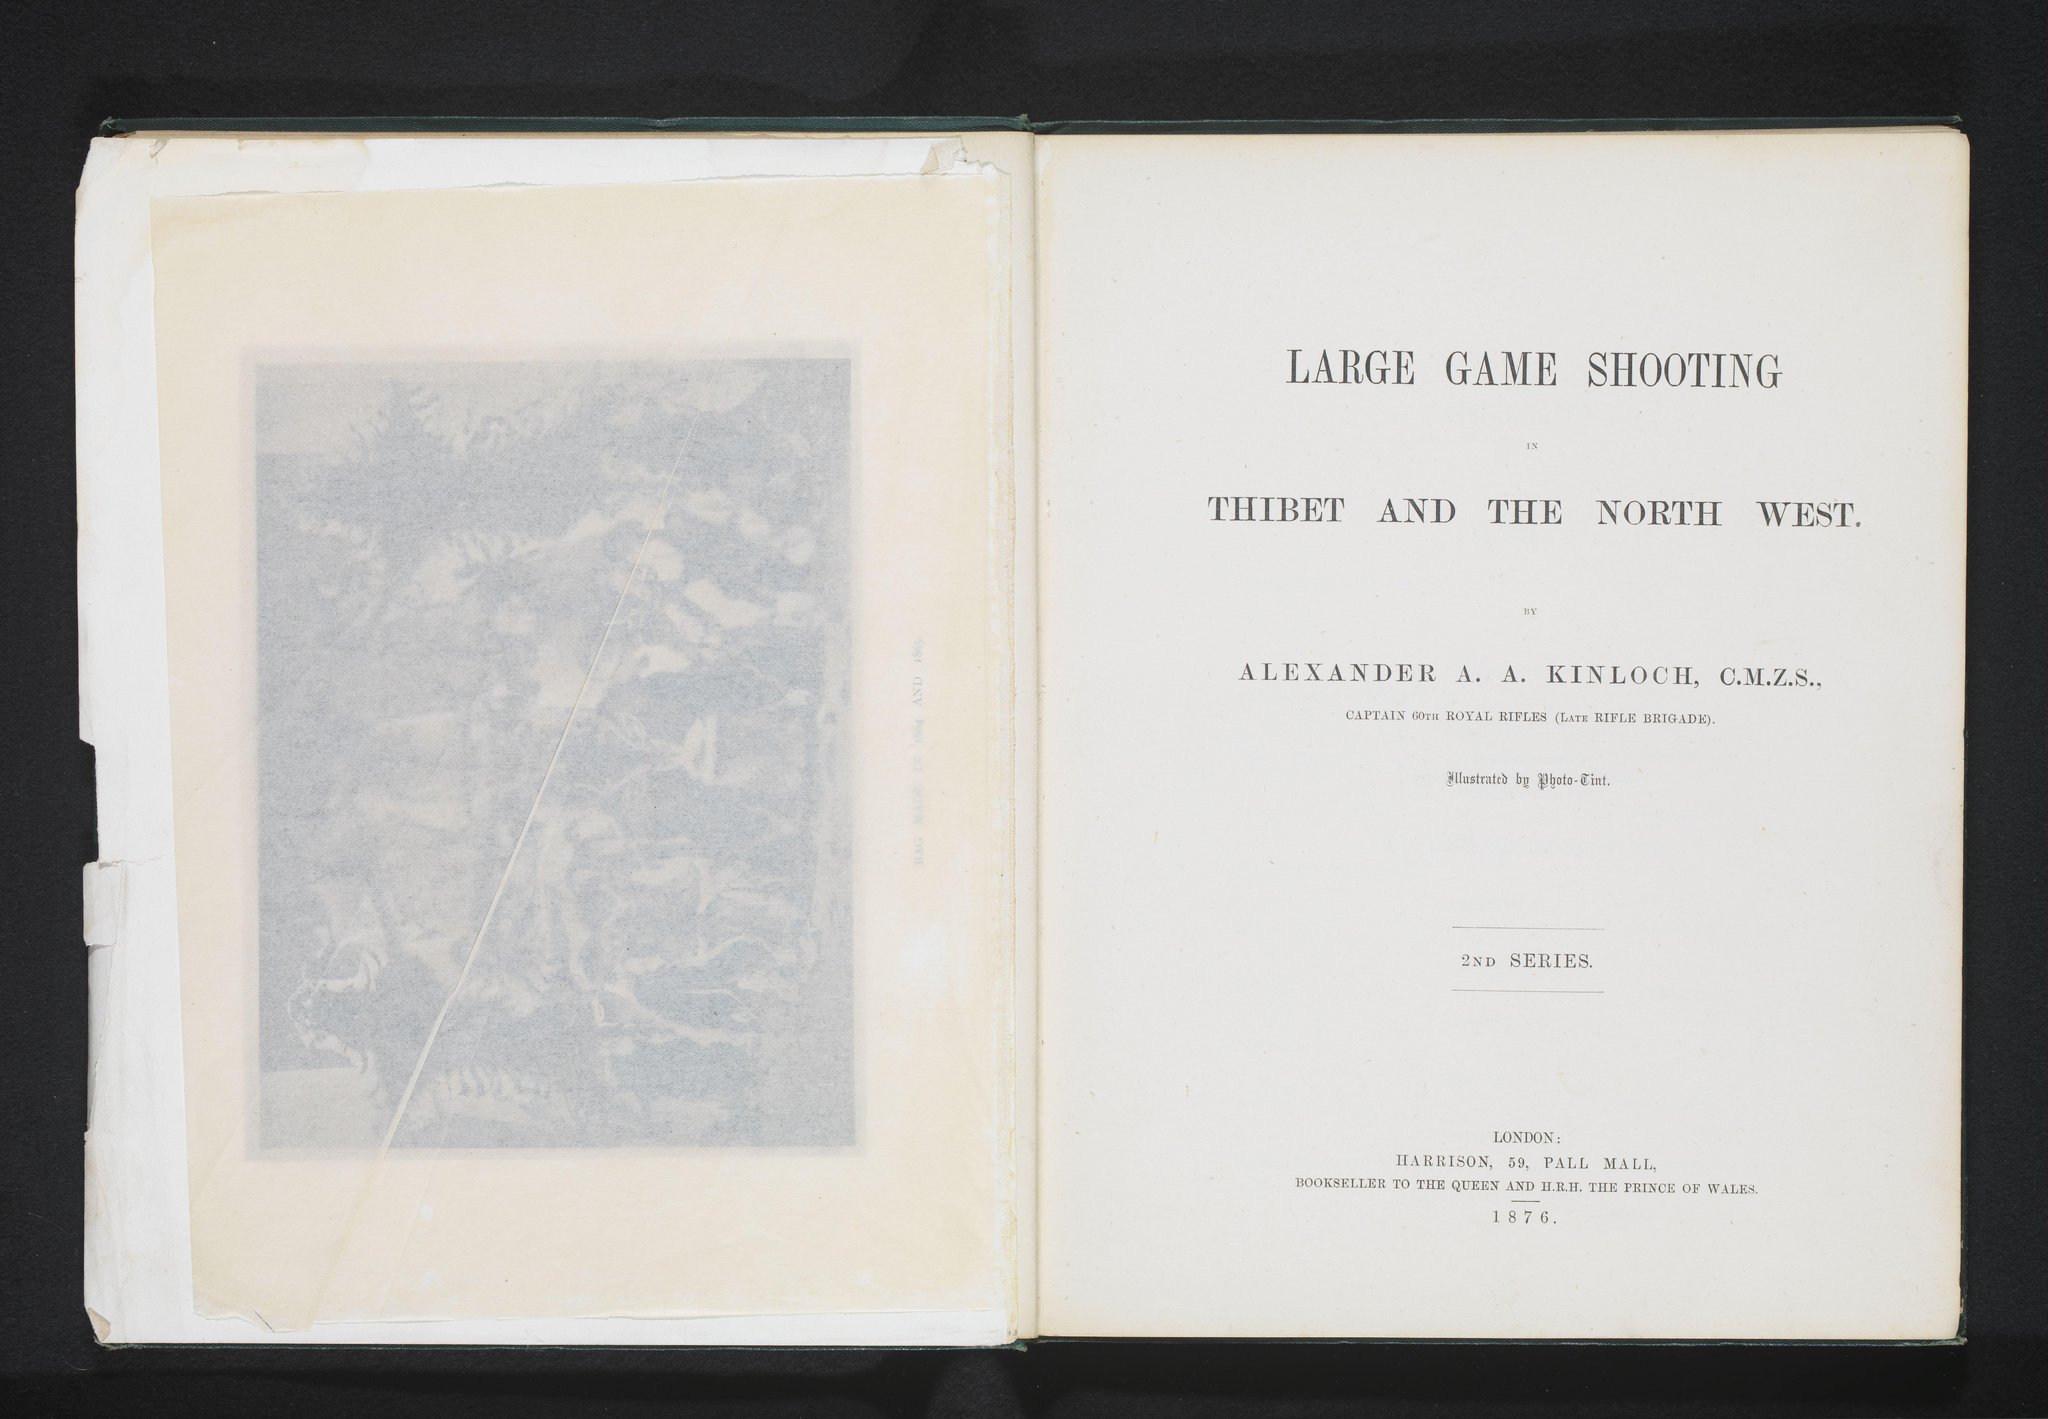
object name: book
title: Large game shooting in Thibet and the north west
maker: alexander a.a. kinloch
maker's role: traveler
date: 1876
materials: cardboard, linen, paper, photographic support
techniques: photograph, printing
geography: london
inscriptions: name: ‘Rowland Ward Ltd. 166 Piccadilly London’, name: ‘London: Harrison, 59, Pall Mall, Bookseller to the queen and H.R.H the prince of Wales. 1876.’